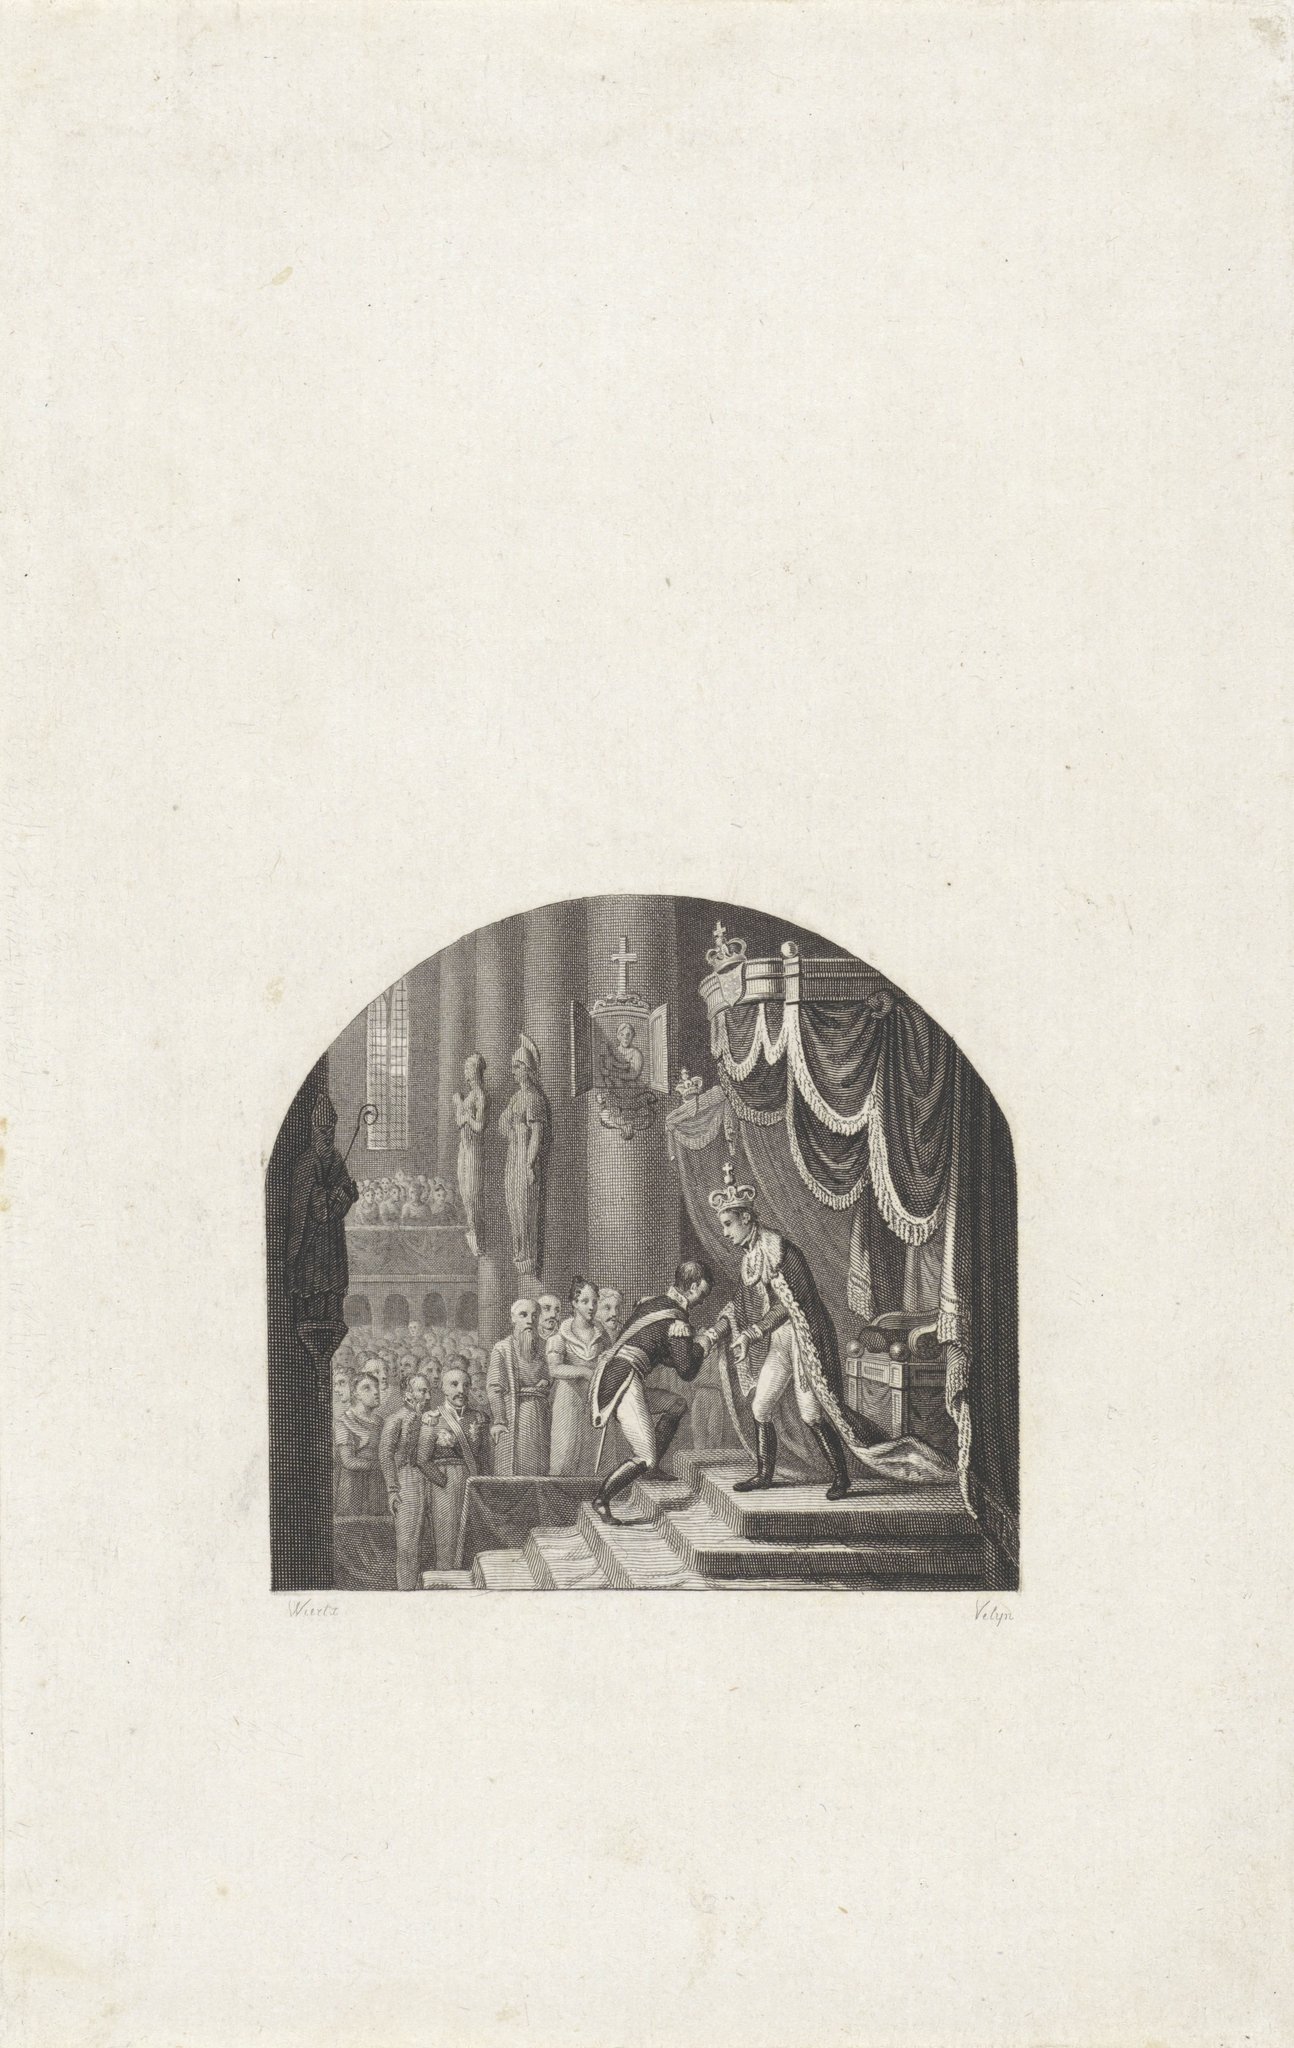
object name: print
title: Man knielt voor een koning in een kerk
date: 1797-1836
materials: paper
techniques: engraving, etching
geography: netherlands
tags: canopy, baldachin, interior of church, ruler, sovereign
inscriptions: collector's mark: Lugt 2228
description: Een man knielt voor een koning, die van zijn troon is opgestaan, onder een baldakijn in een kerk. In de kerk kijkt een groot publiek toe. Aan de zuilen heiligenbeelden.